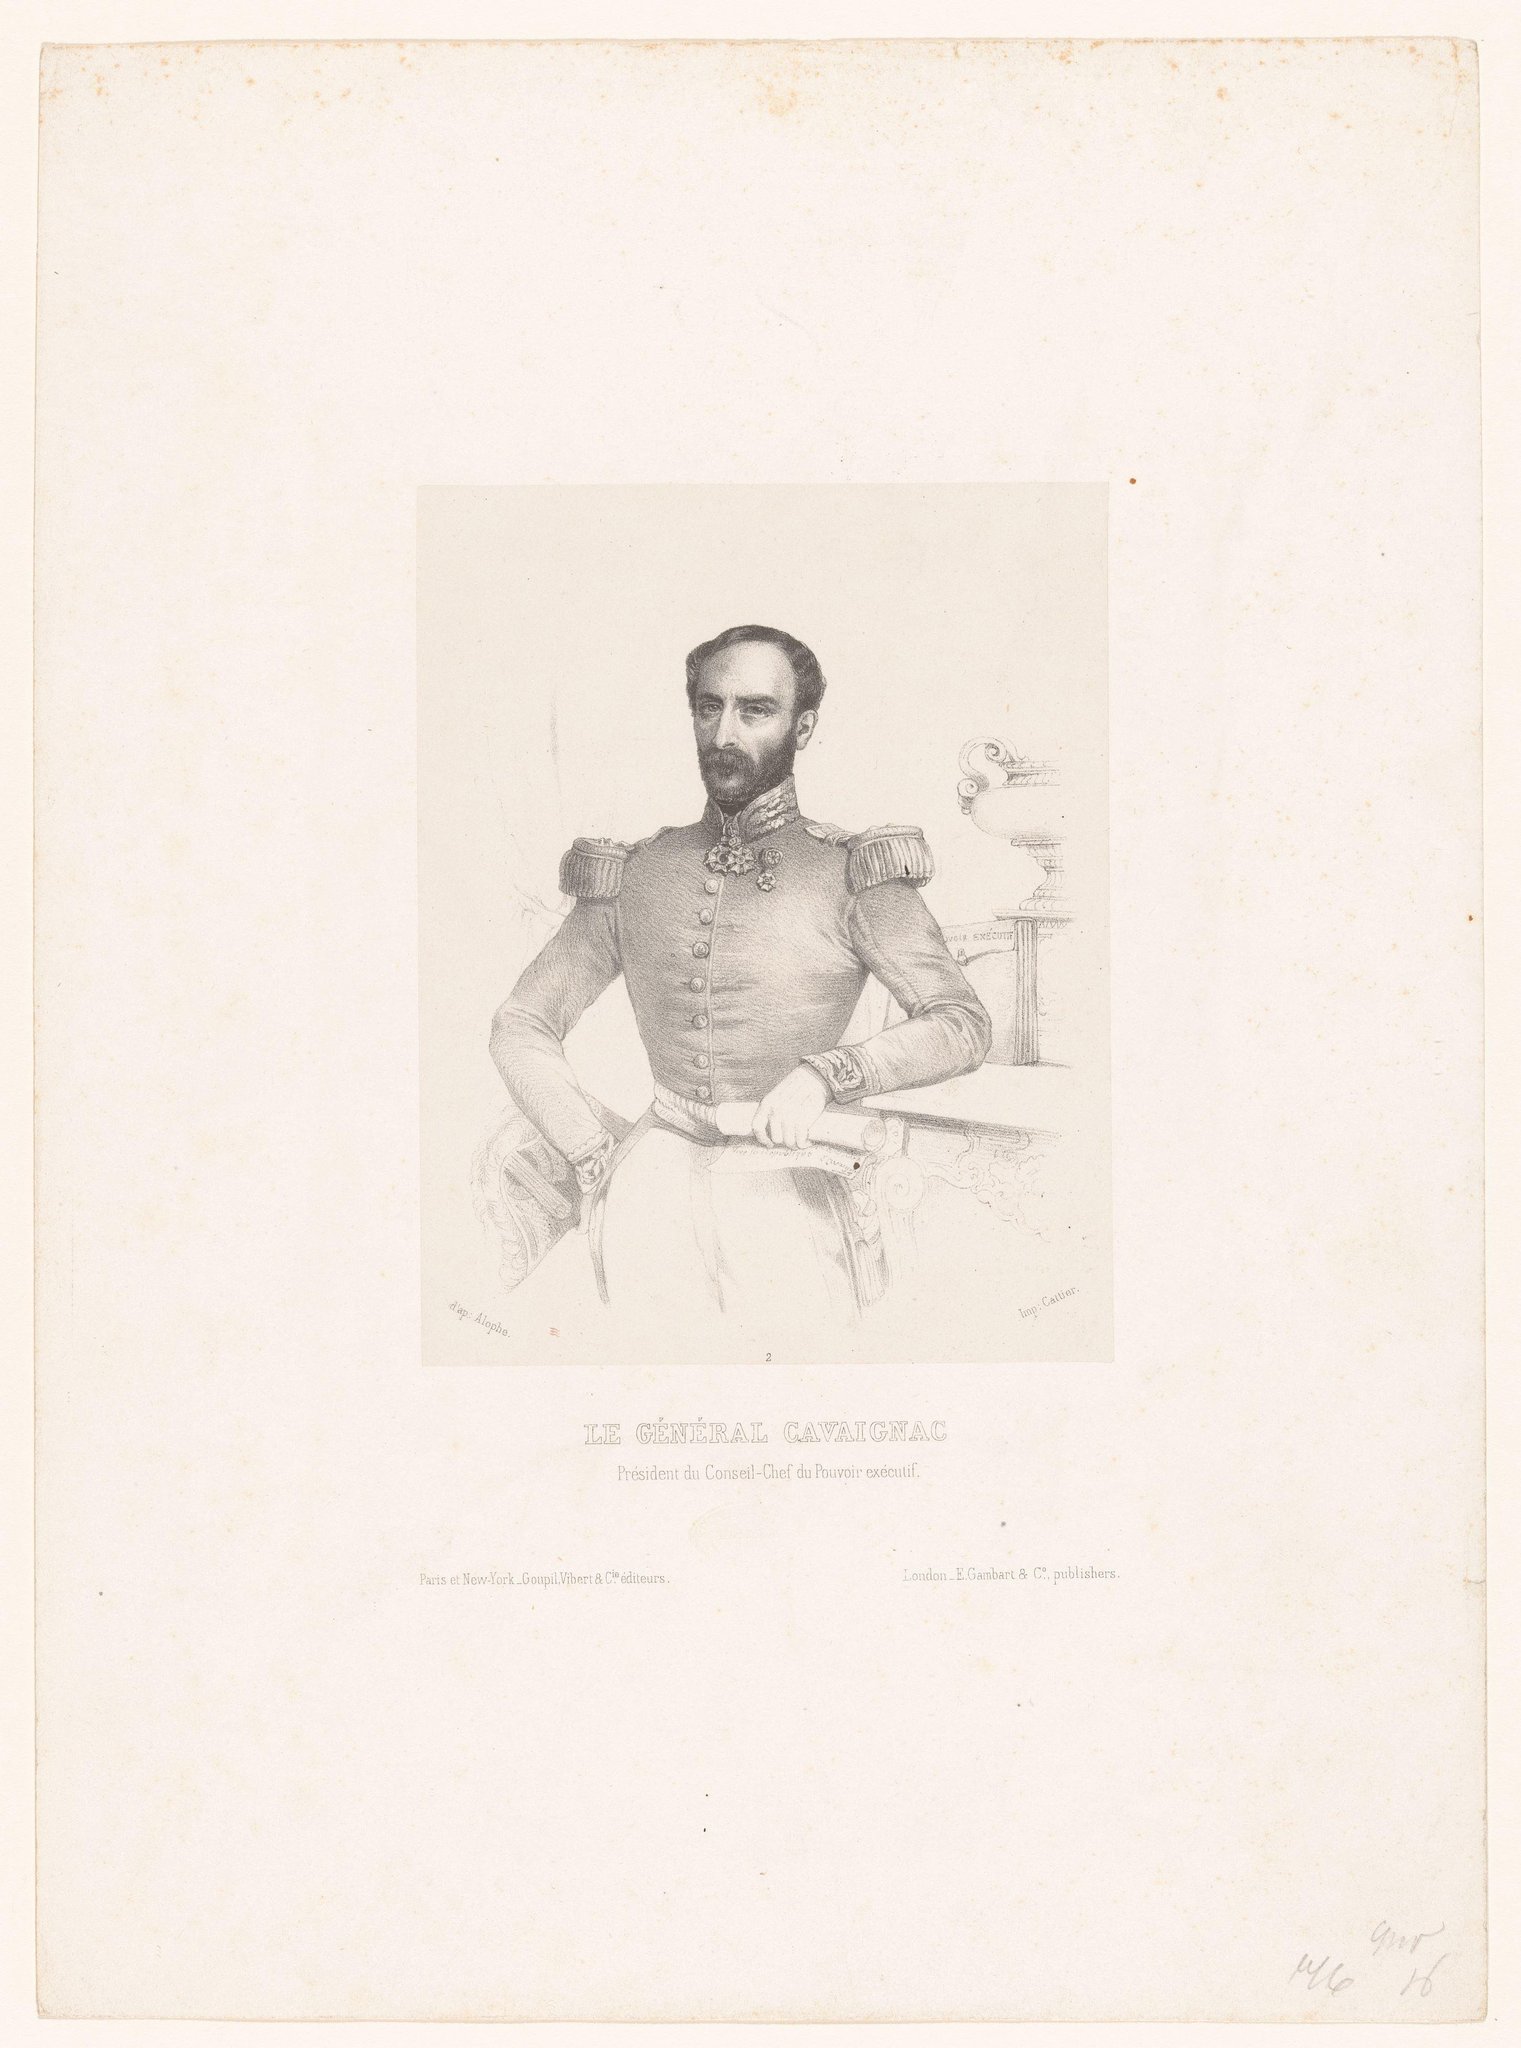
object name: print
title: Portret van generaal Louis Eugène Cavaignac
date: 1848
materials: paper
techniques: lithography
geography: paris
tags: historical persons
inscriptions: number: ‘[...] 16’, check stamp: Lugt 5004, collector's mark: Lugt 2228